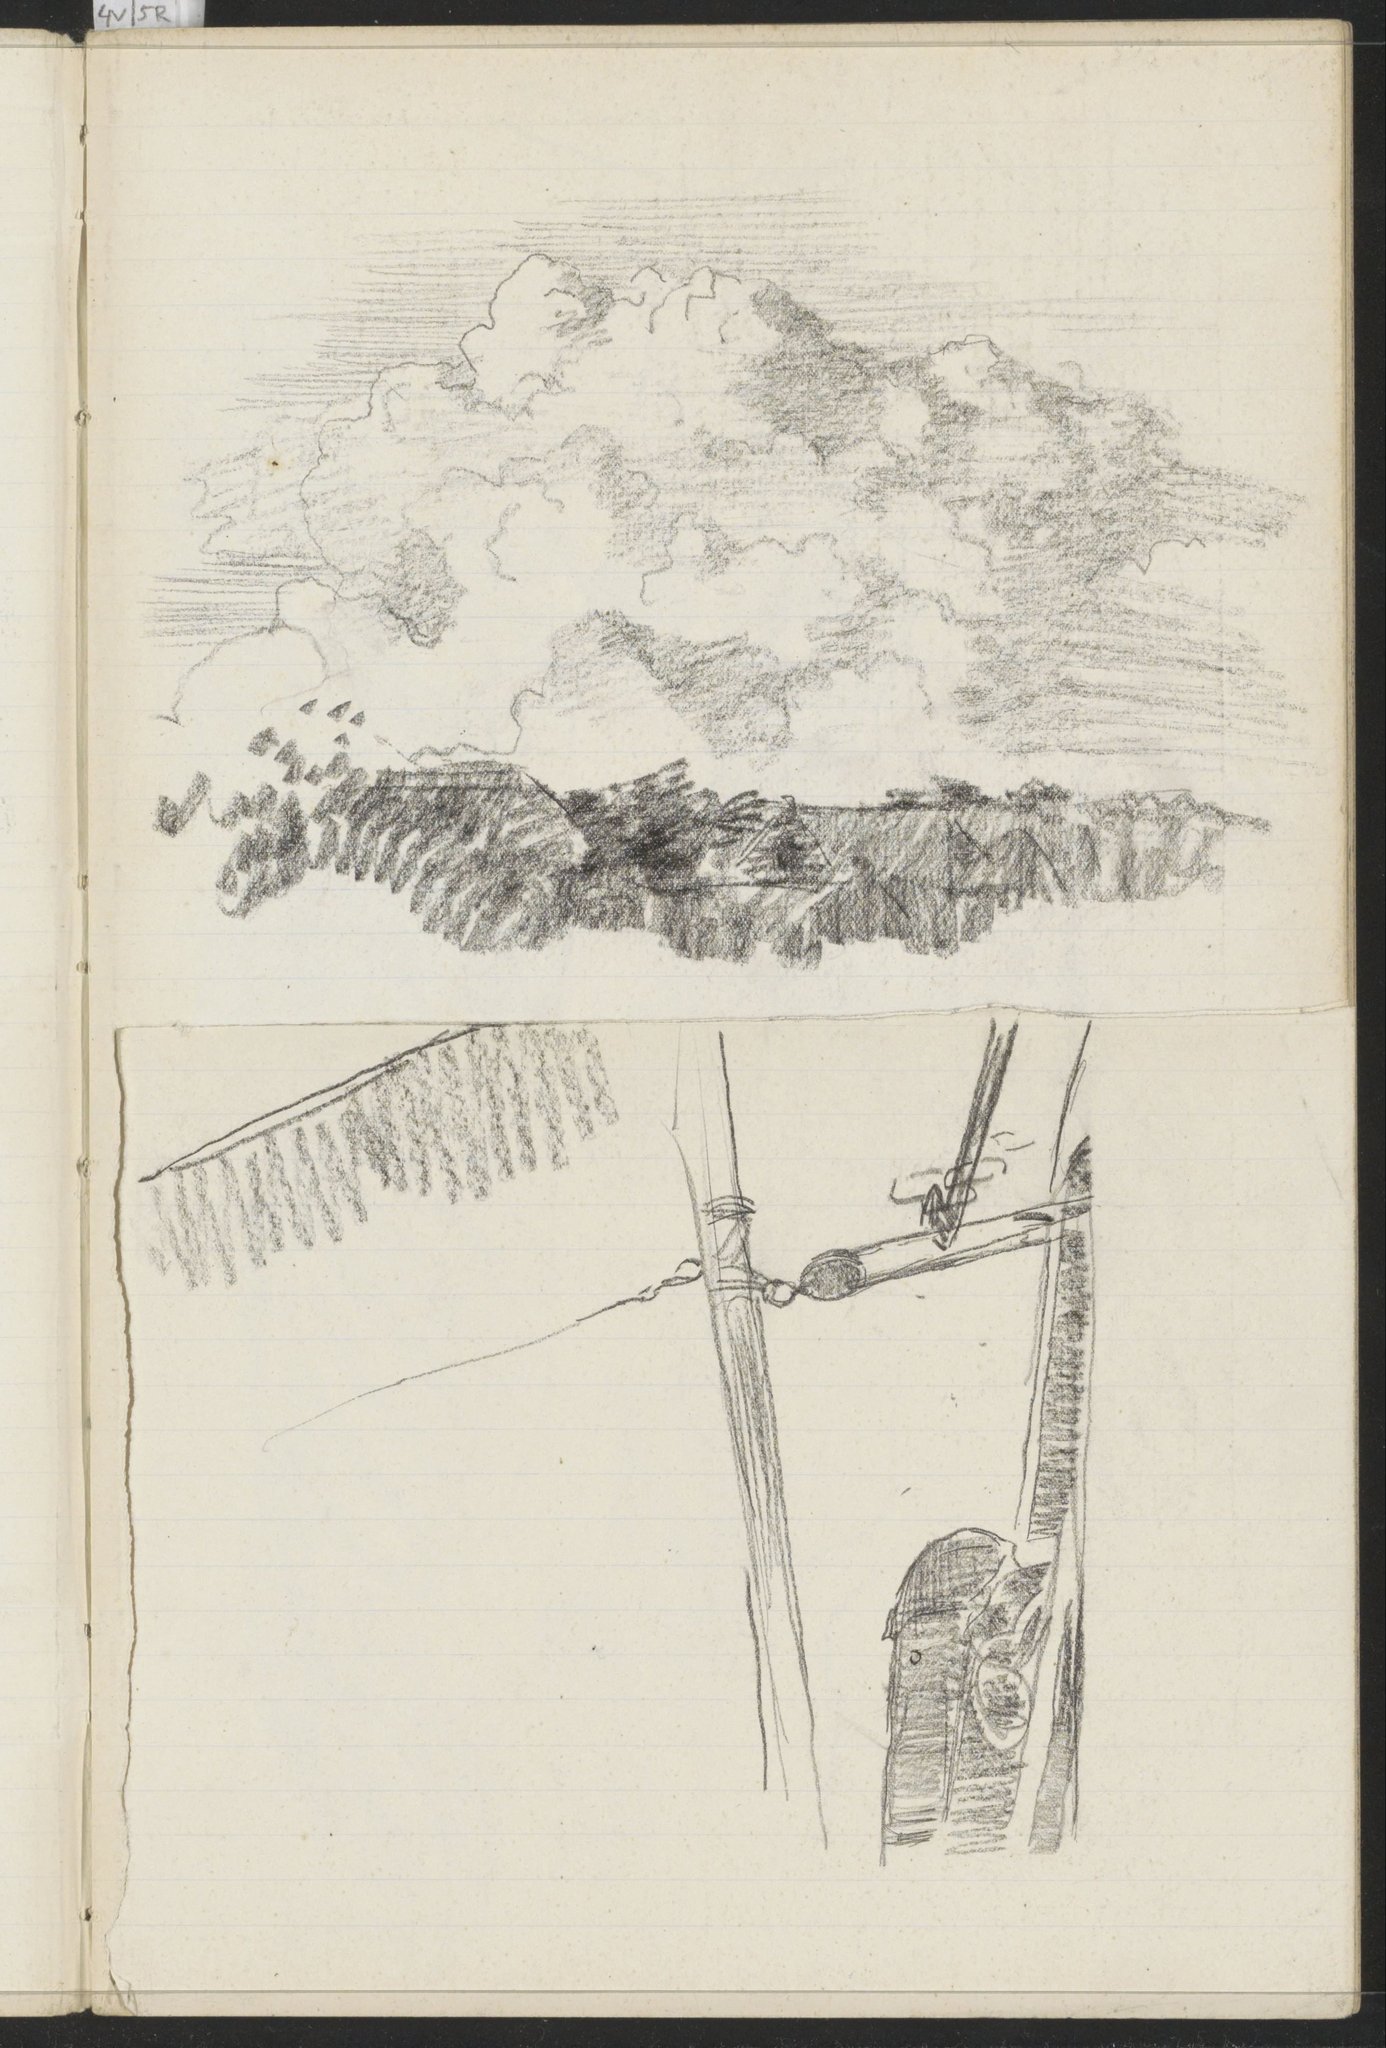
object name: sketchbook leaf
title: Wolken boven huizen en een mast van een zeilschip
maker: willem bastiaan tholen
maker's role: draughtsman, painter, print maker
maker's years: 1860-1931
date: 1900-1931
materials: chalk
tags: city-view, and landscape with man-made constructions, clouds, parts of ship's exterior: mast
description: De pagina is over het midden gescheurd. De schets van de mast zit los.